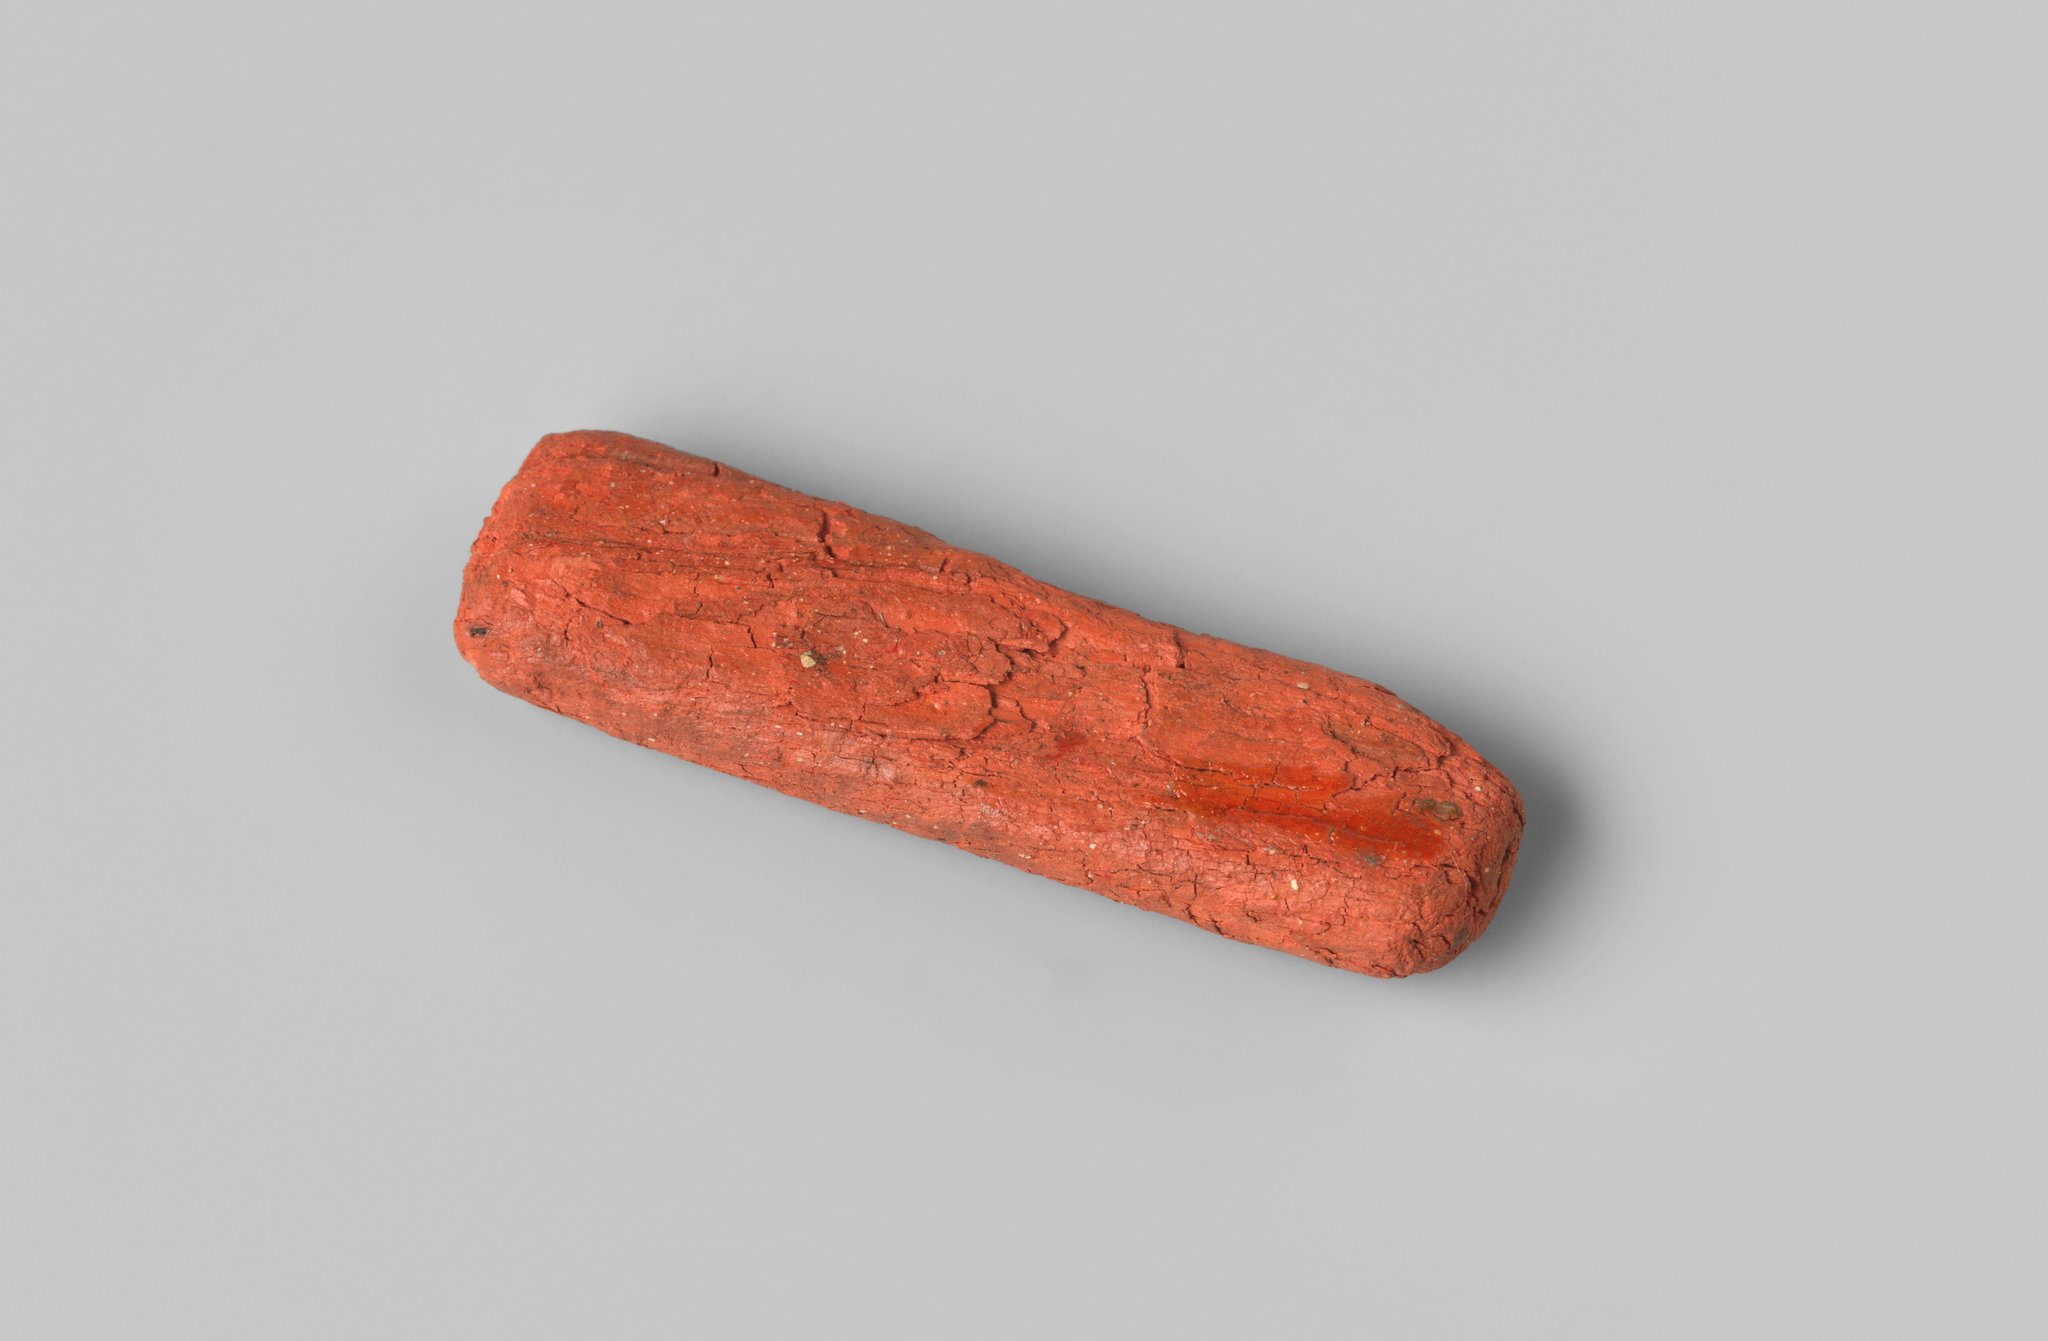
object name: sealing wax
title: Zegellak uit het wrak van de Oost-Indiëvaarder Hollandia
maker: Anonymous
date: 1700-1743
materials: wax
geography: netherlands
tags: verenigde oostindische compagnie, hollandia (schip), annet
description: Marking and proving, sealing wax, red; id. NG 1975-50H446, one rounded end, mark eroded.